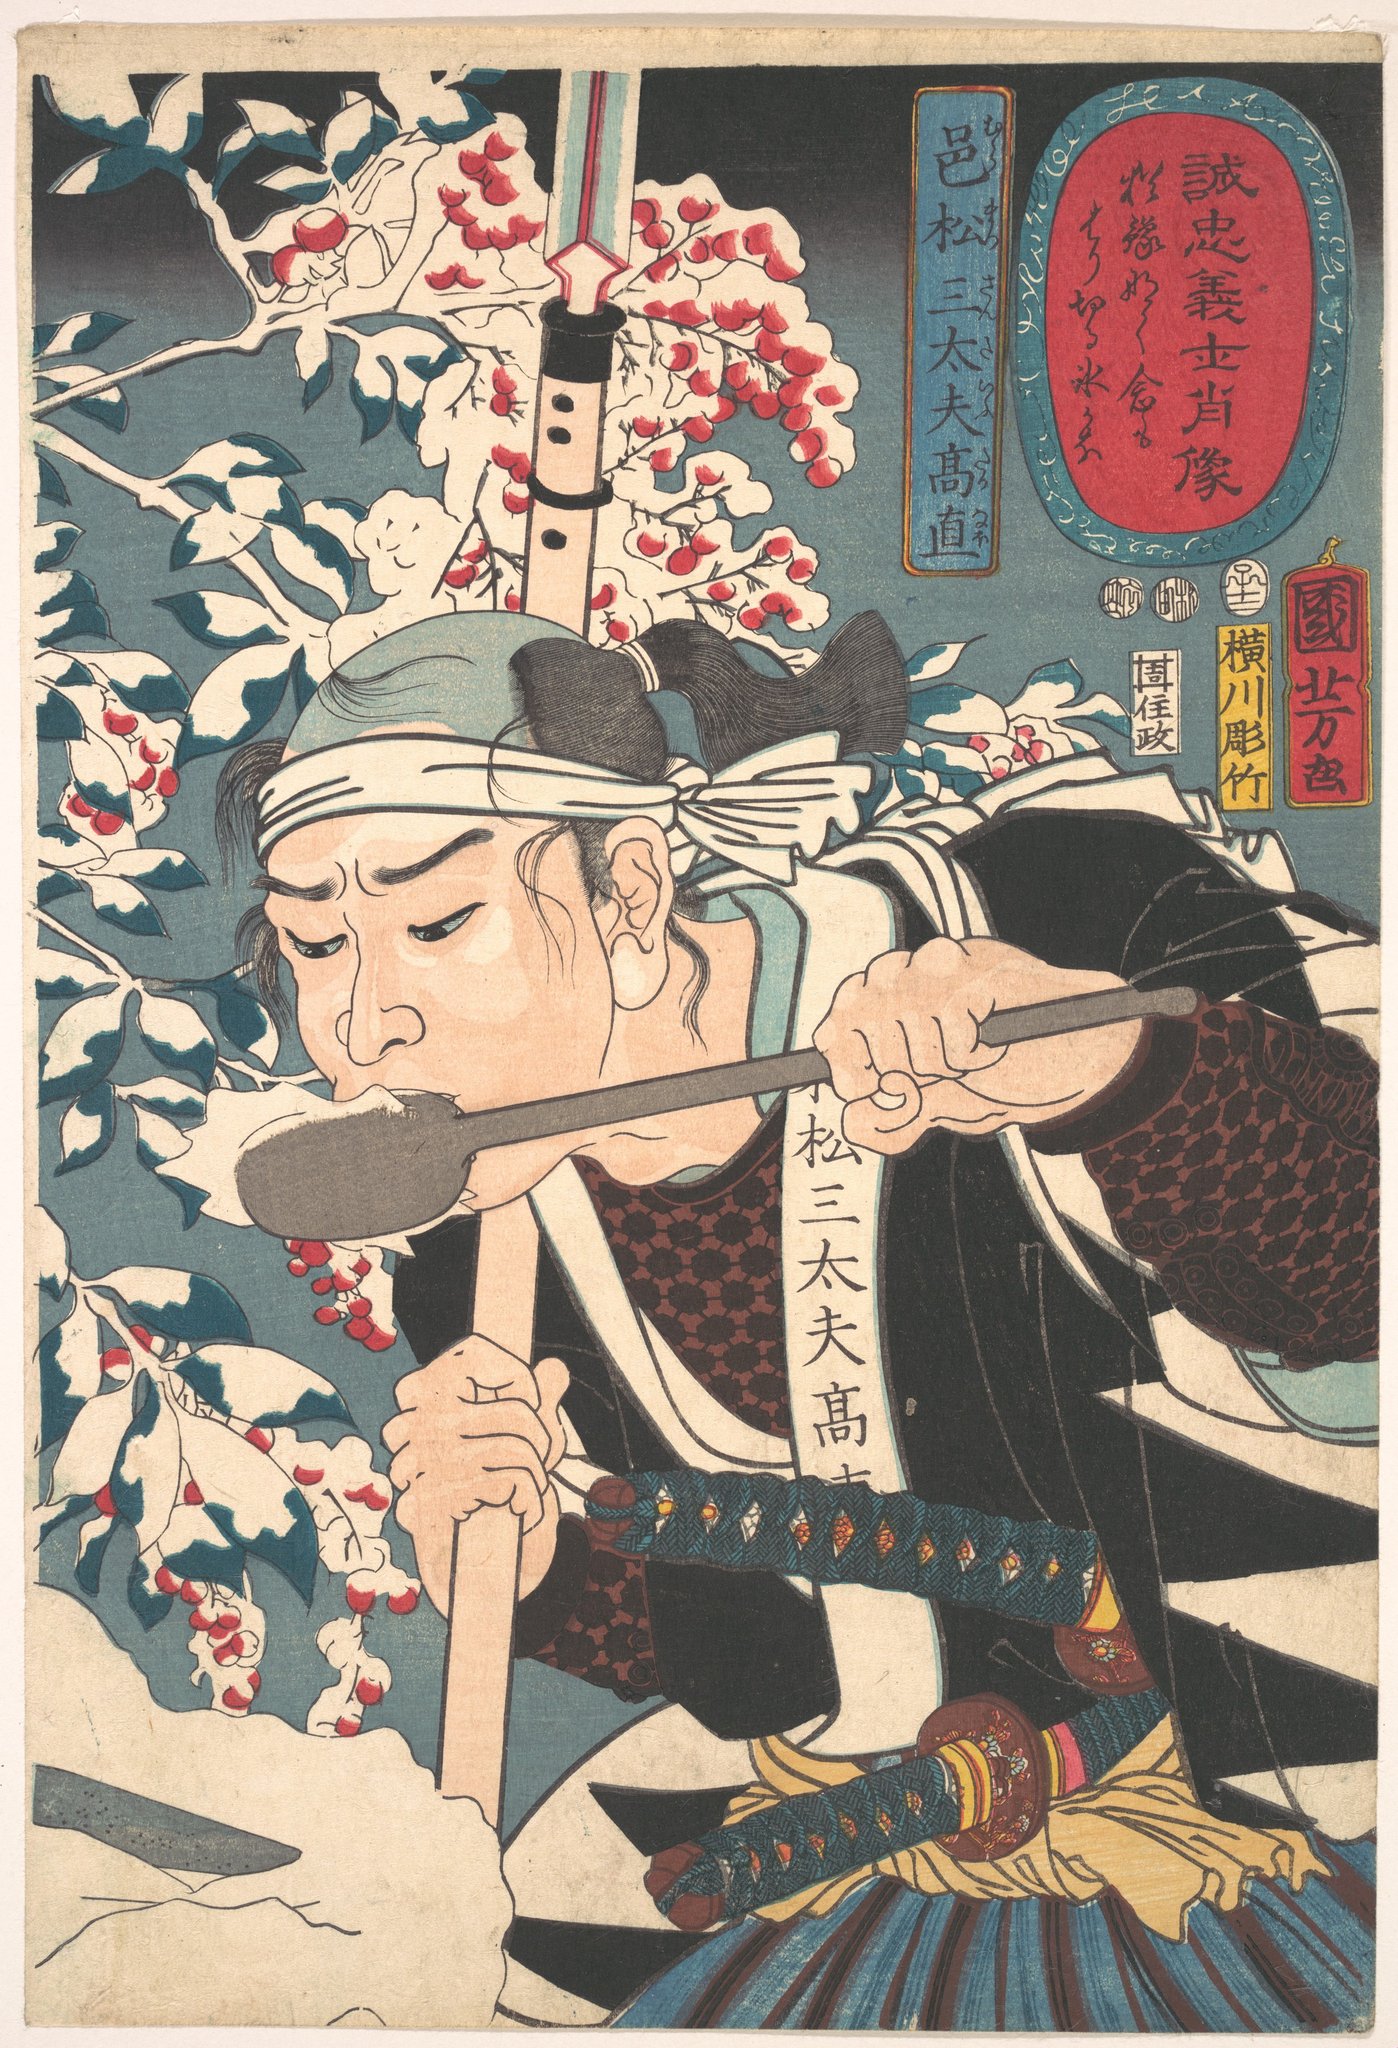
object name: woodblock print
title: Portrait of Muramatsu Sandayu Takanao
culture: japanese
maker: utagawa kuniyoshi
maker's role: artist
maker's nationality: japanese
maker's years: 1797-1861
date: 1852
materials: ink, paper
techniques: woodblock print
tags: men,portraits